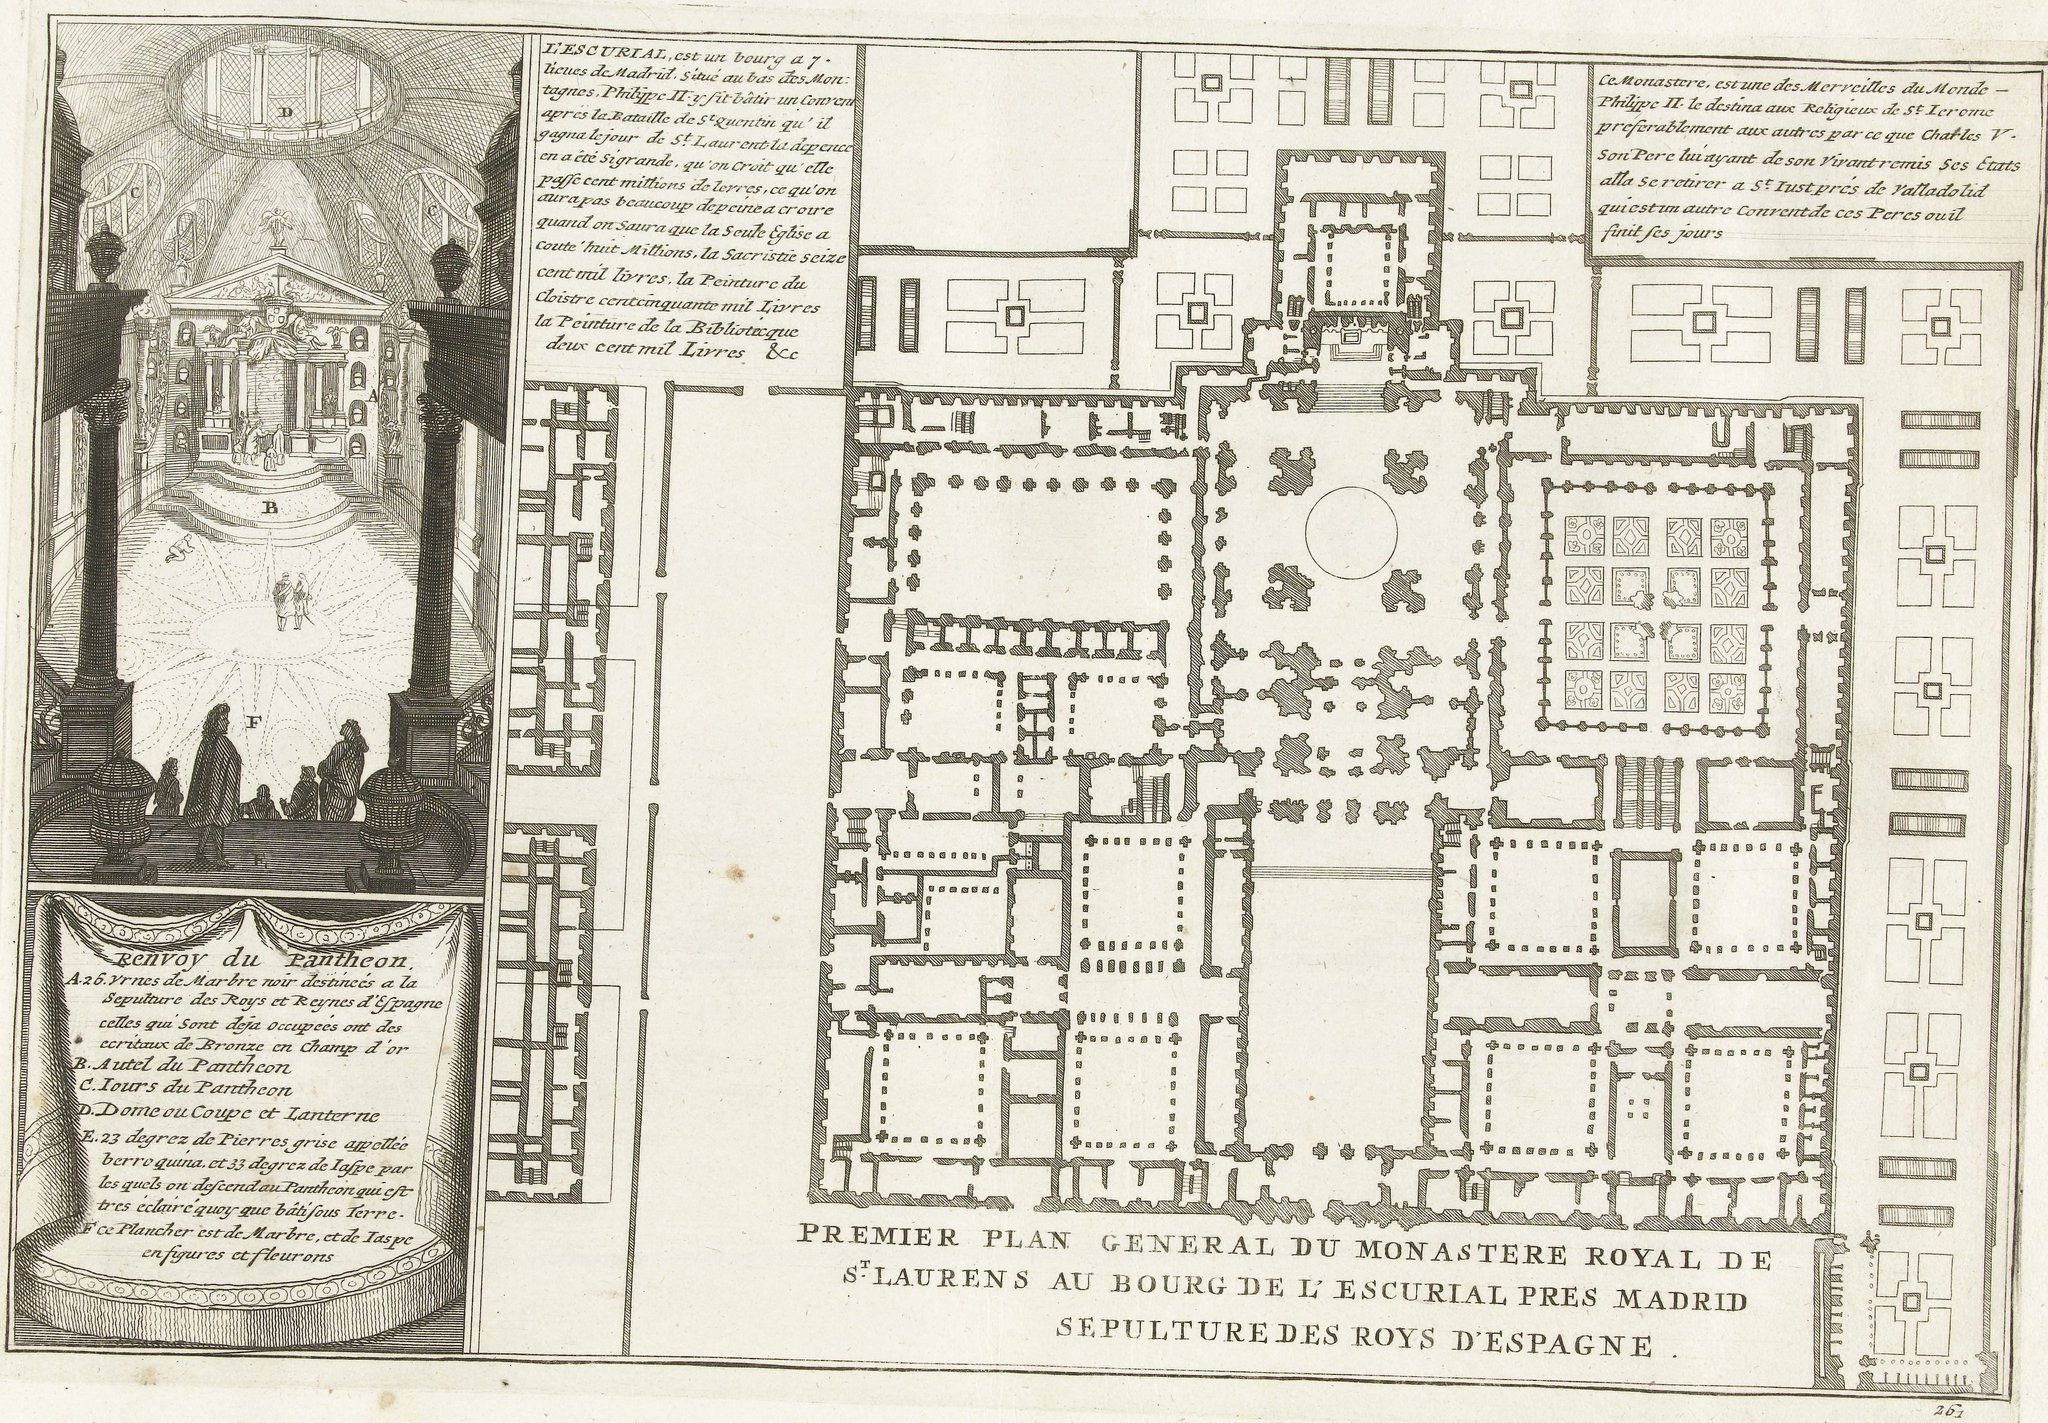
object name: print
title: Les Forces de l'Europe, Asie, Afrique et Amerique, ou description des principales villes avec leurs fortifications. Dessignées par les meilleurs ingenieurs, particulierement celles qui sont sous la domination de la France (...) et ornées de plusieurs superbes edifices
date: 1702-1703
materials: paper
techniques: etching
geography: northern netherlands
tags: plan ~ architecture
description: Plattegrond van het Escorial. Plaat nr. 261 in het prentwerk bestaande in totaal uit 276 genummerde platen van vermaarde sterke steden en vestingen in het kader van de Spaanse Successieoorlog. Voor het merendeel zijn deze platen gekopieerd naar de anonieme Franse platen: in Les forces de l'Europe en in: Le theatre de la guerre, dans les Pays-Bas, beide oorspronkelijk uitgegeven door Nicolas de Fer te Parijs (1693-1697) in het kader van de Negenjarige Oorlog. Titel en opschriften in de plaat in het Frans.